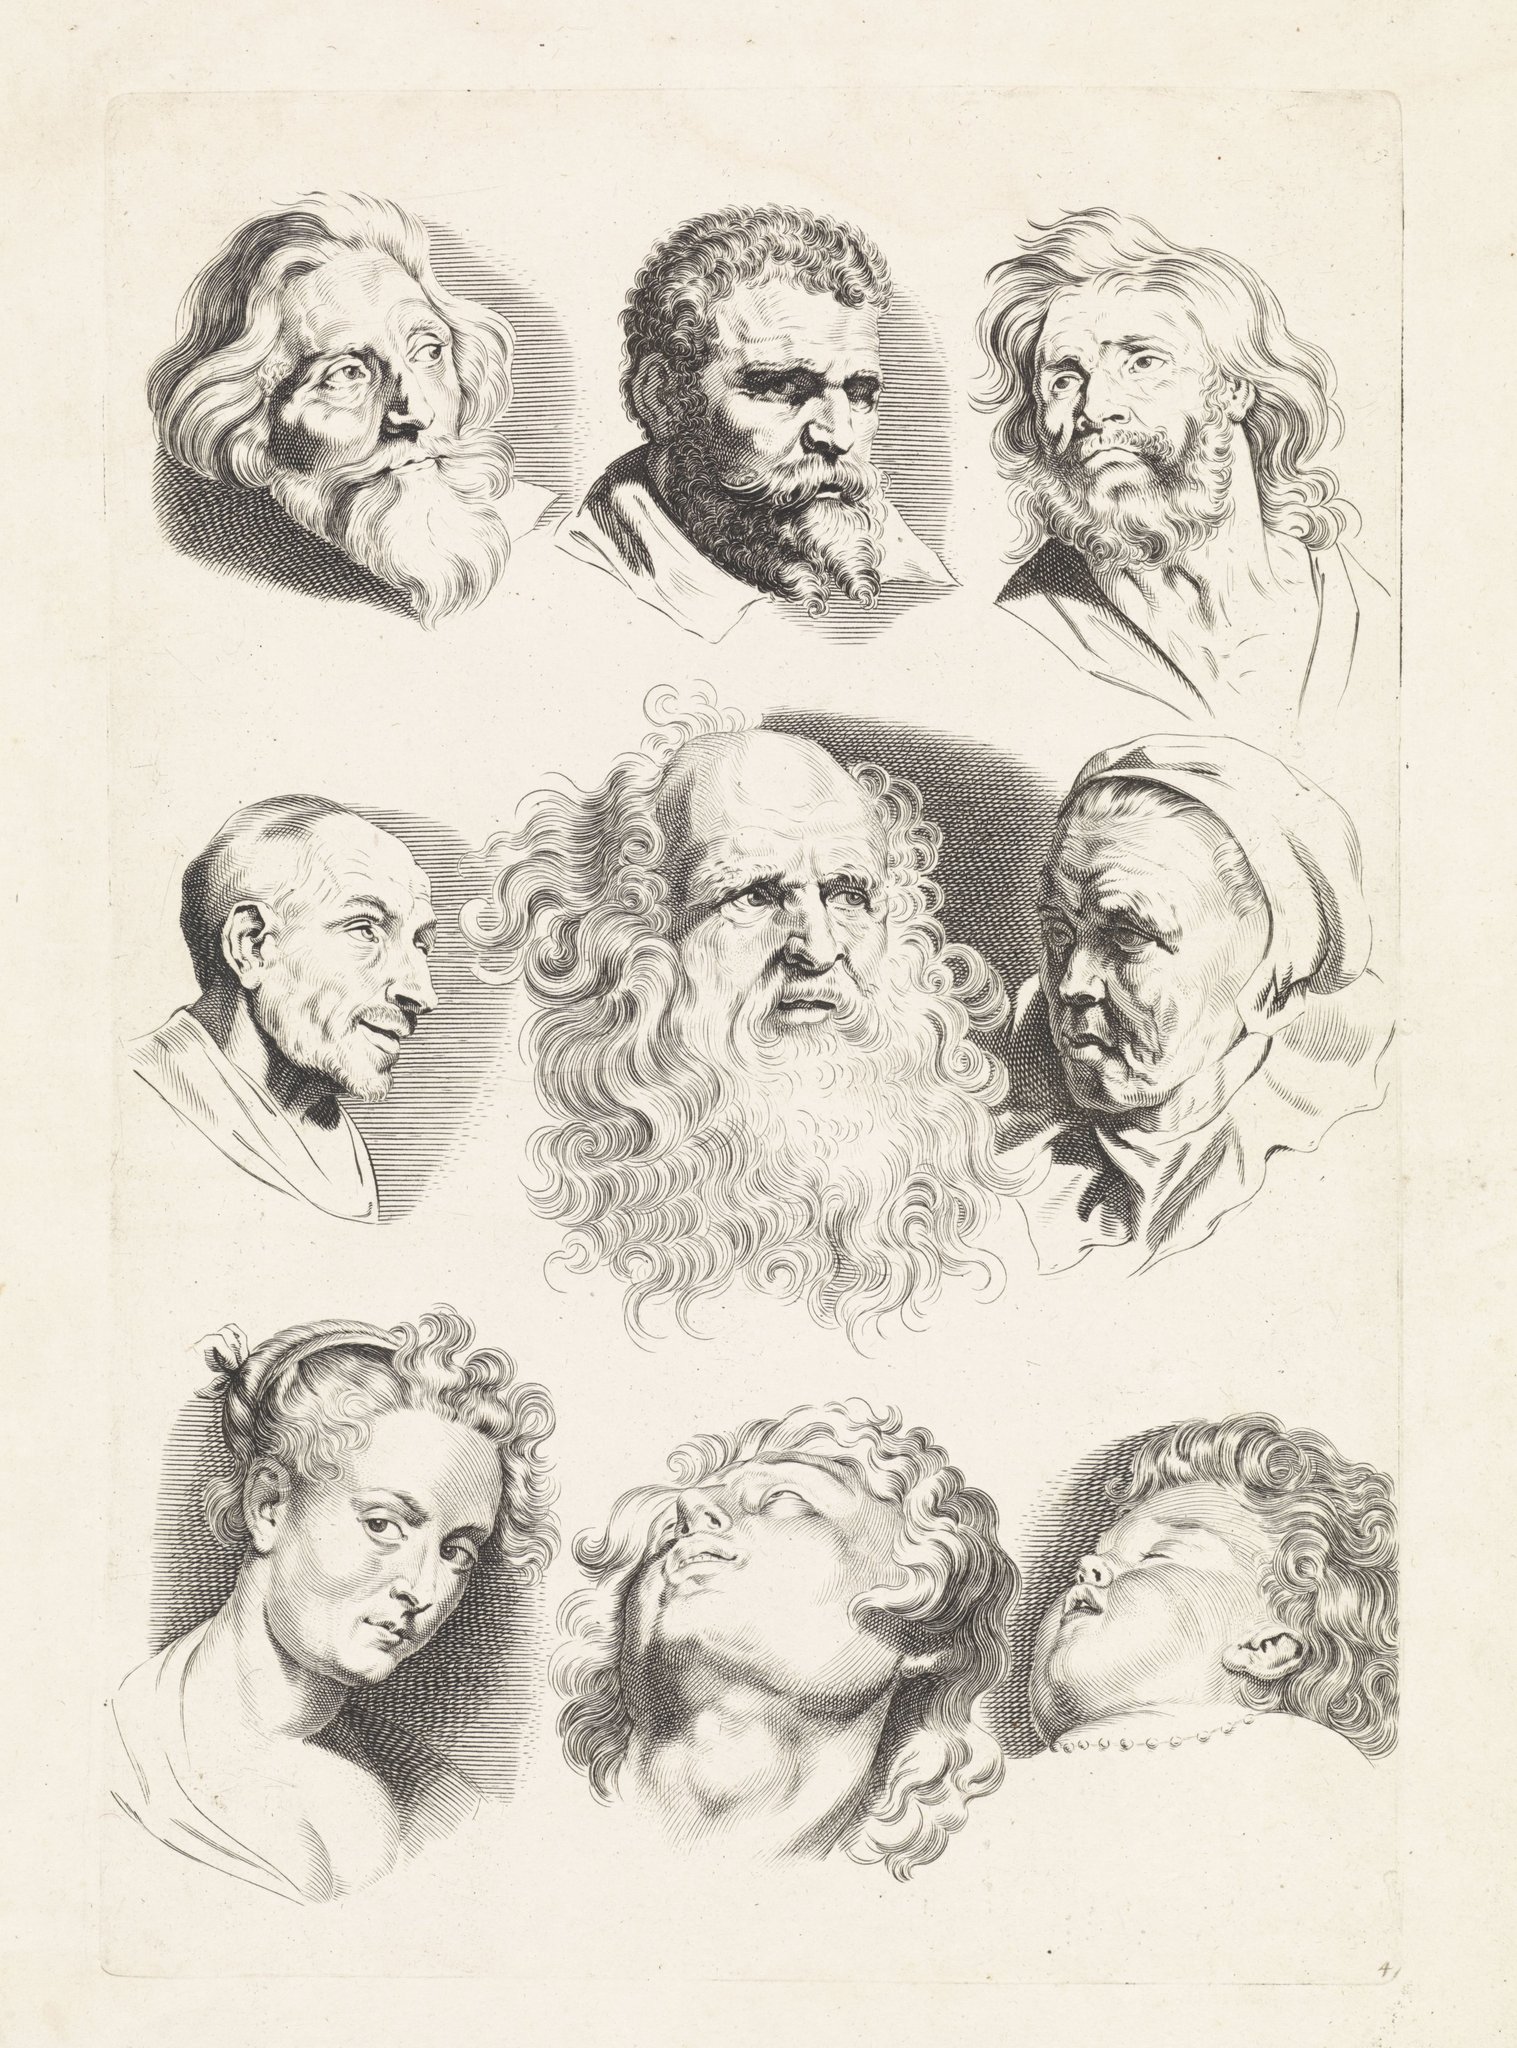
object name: print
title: Studies van negen hoofden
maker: paulus pontius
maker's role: draughtsman, print maker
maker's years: 1603-1658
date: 1616-1657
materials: paper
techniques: engraving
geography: antwerp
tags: human beings (legendary or not) of abnormal proportions, size, strength, etc. (+ head, face)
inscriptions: collector's mark: Lugt 240, number: ‘4’